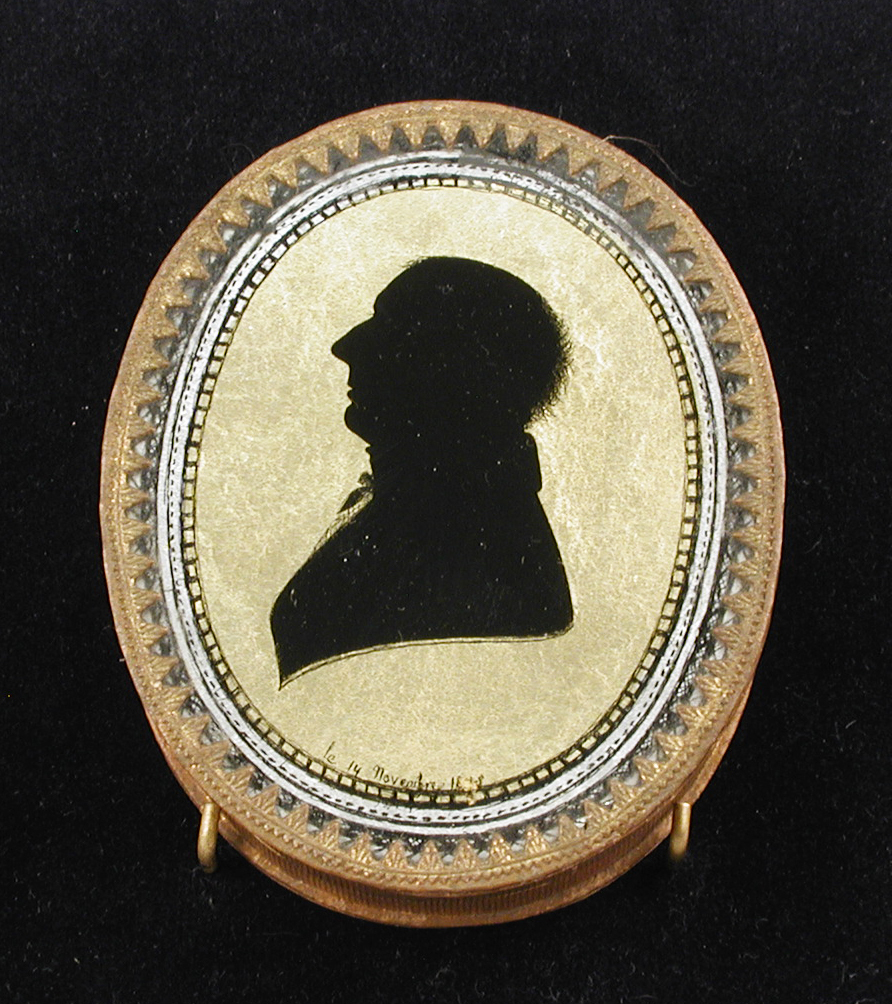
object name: box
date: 1818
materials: glass, paper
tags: men,profiles